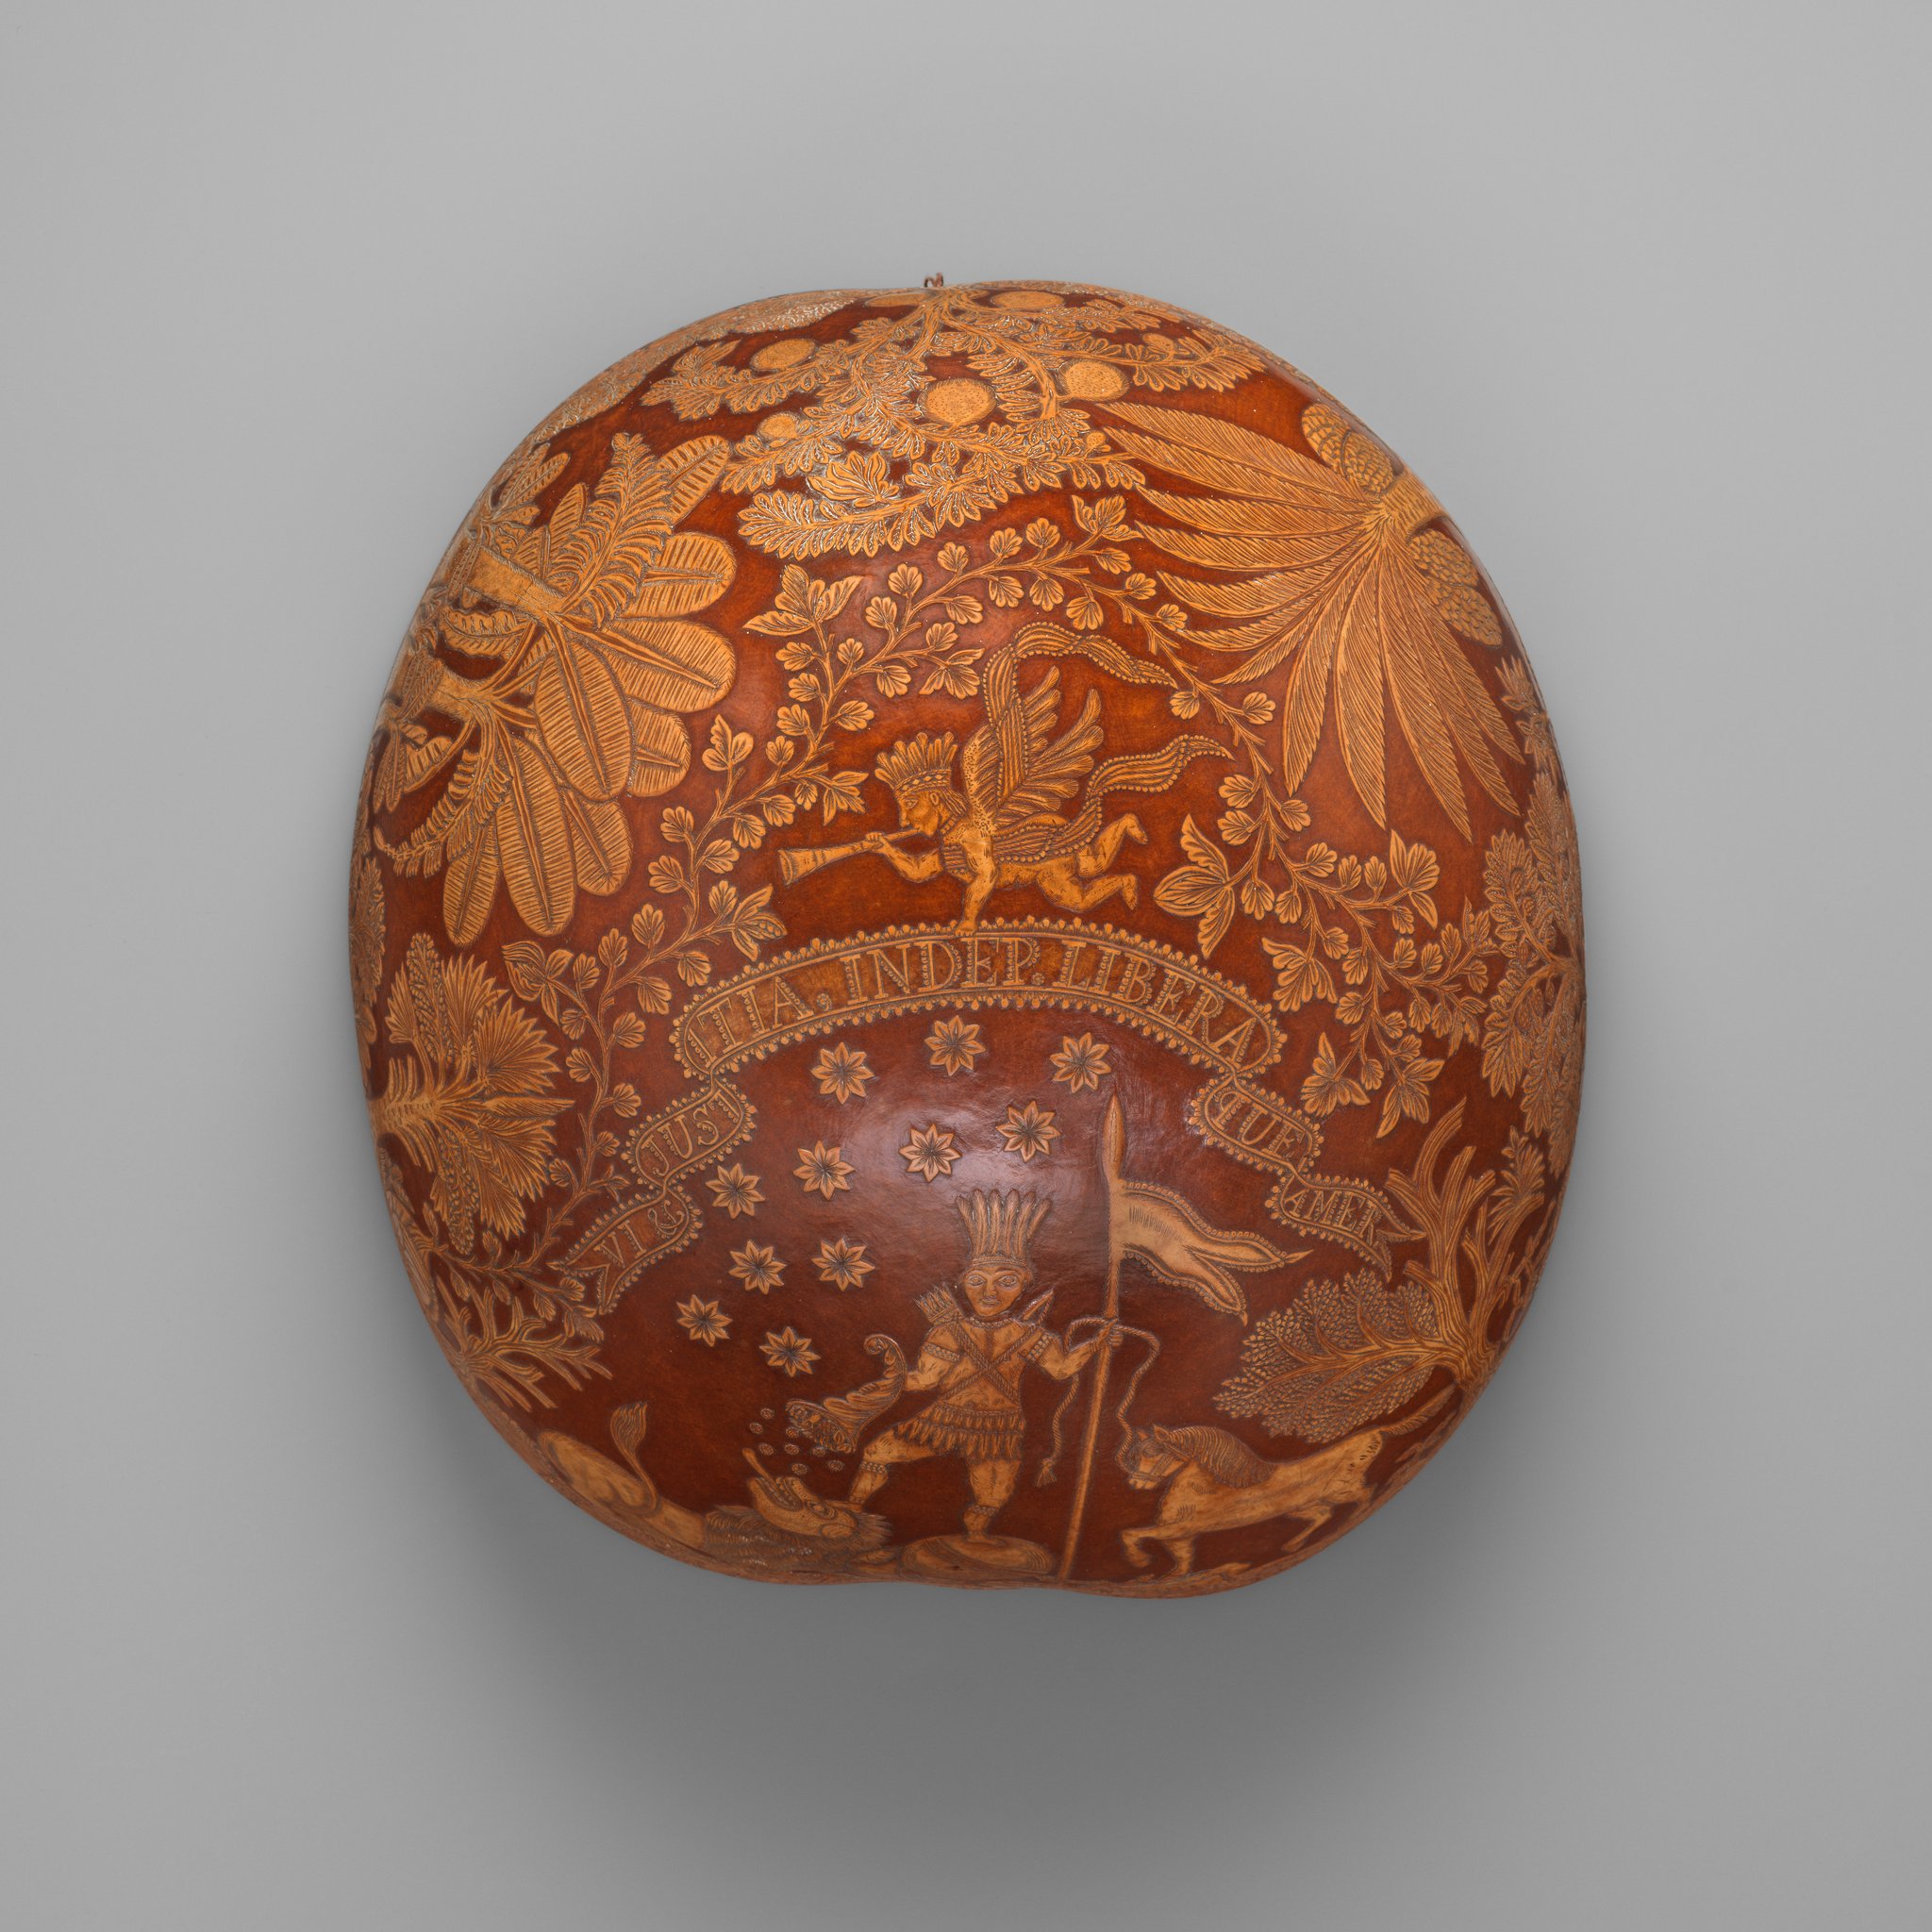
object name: gourd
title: Gourd Bowl Commemorating Independence from Spain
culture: mexican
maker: Anonymous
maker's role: artist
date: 1821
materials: pigment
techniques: carving